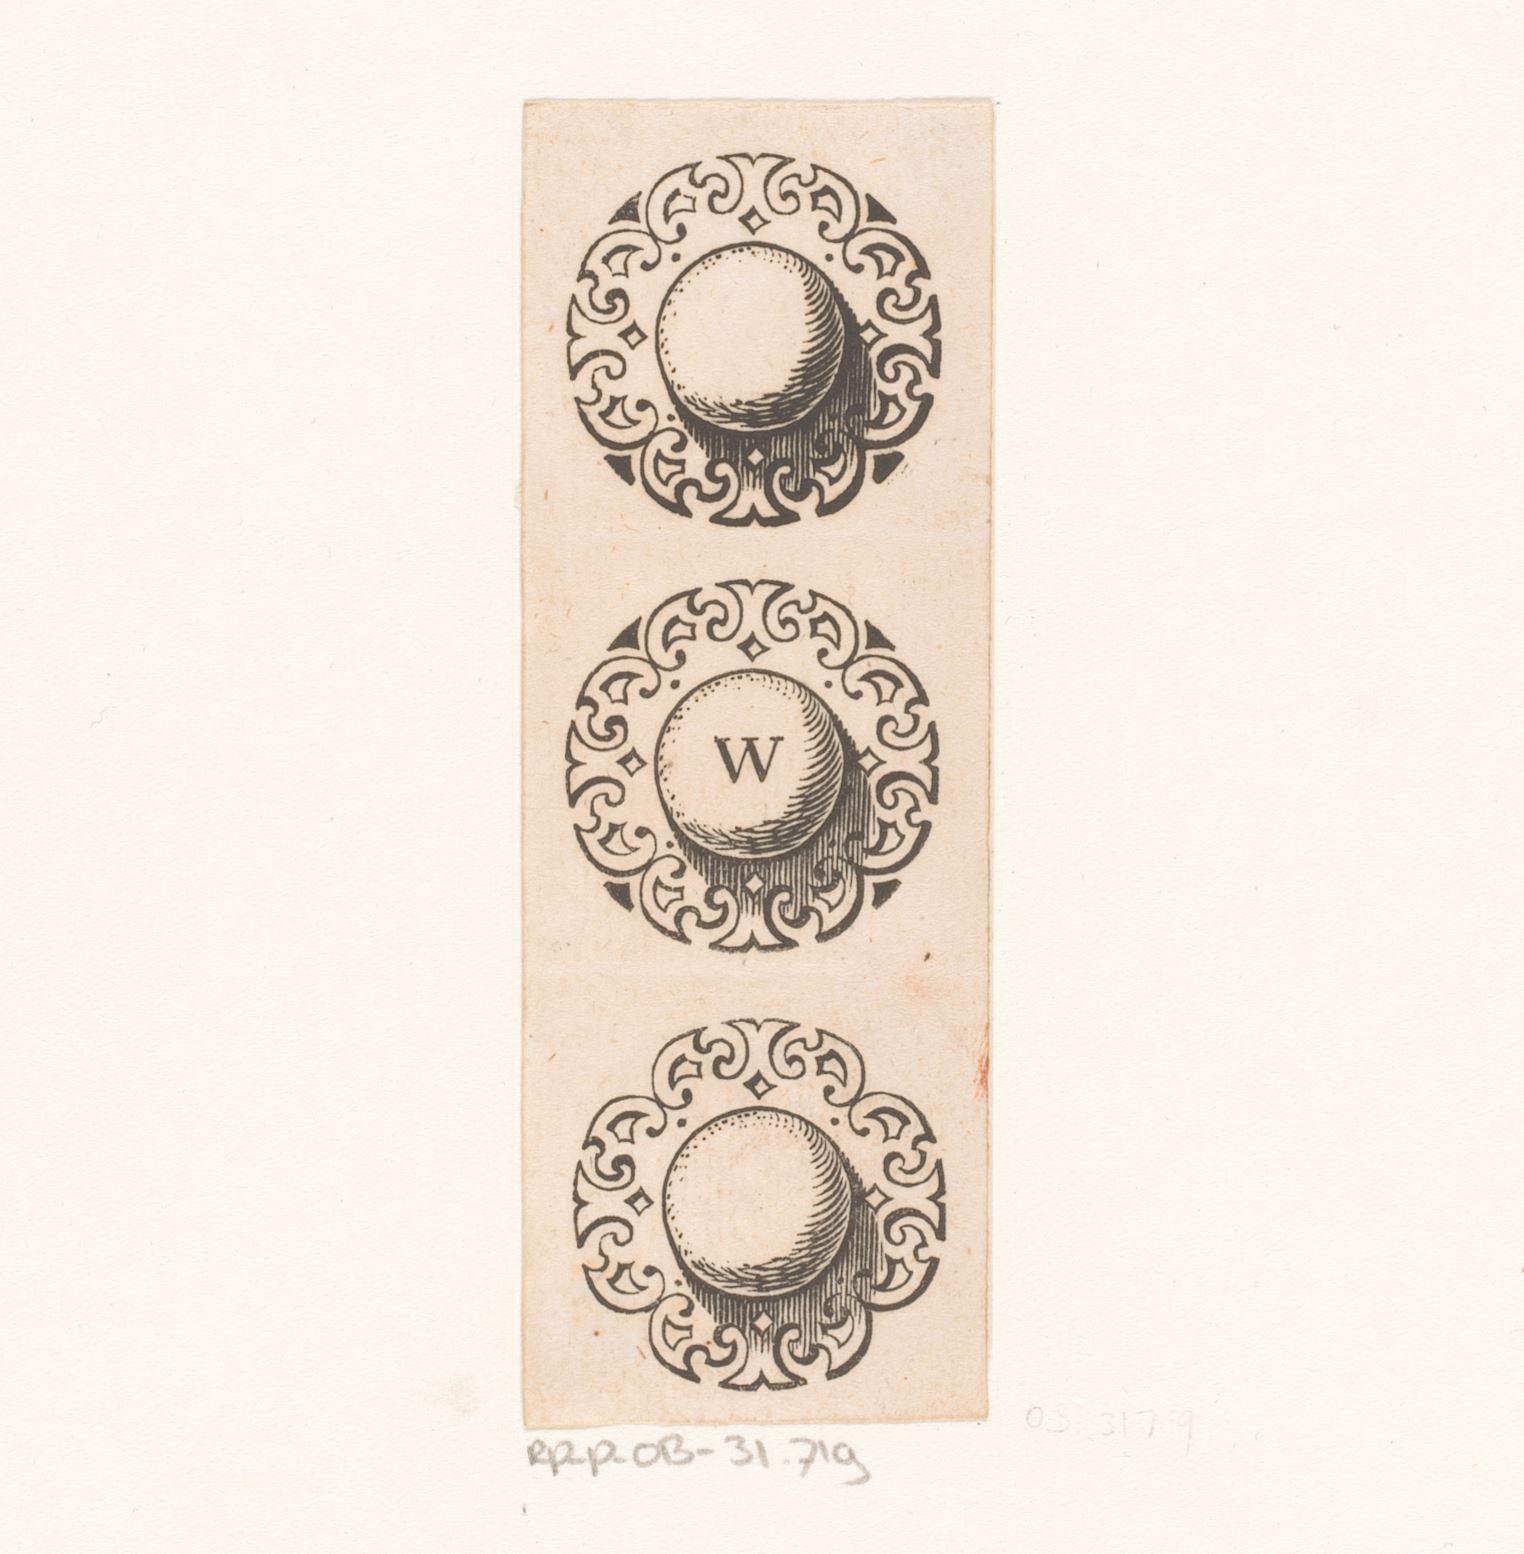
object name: print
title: Drie ornamenten met in het midden de letter W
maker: Anonymous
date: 1600-1699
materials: paper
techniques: woodcut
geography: netherlands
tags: ornaments ~ art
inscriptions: collector's mark: Lugt 240